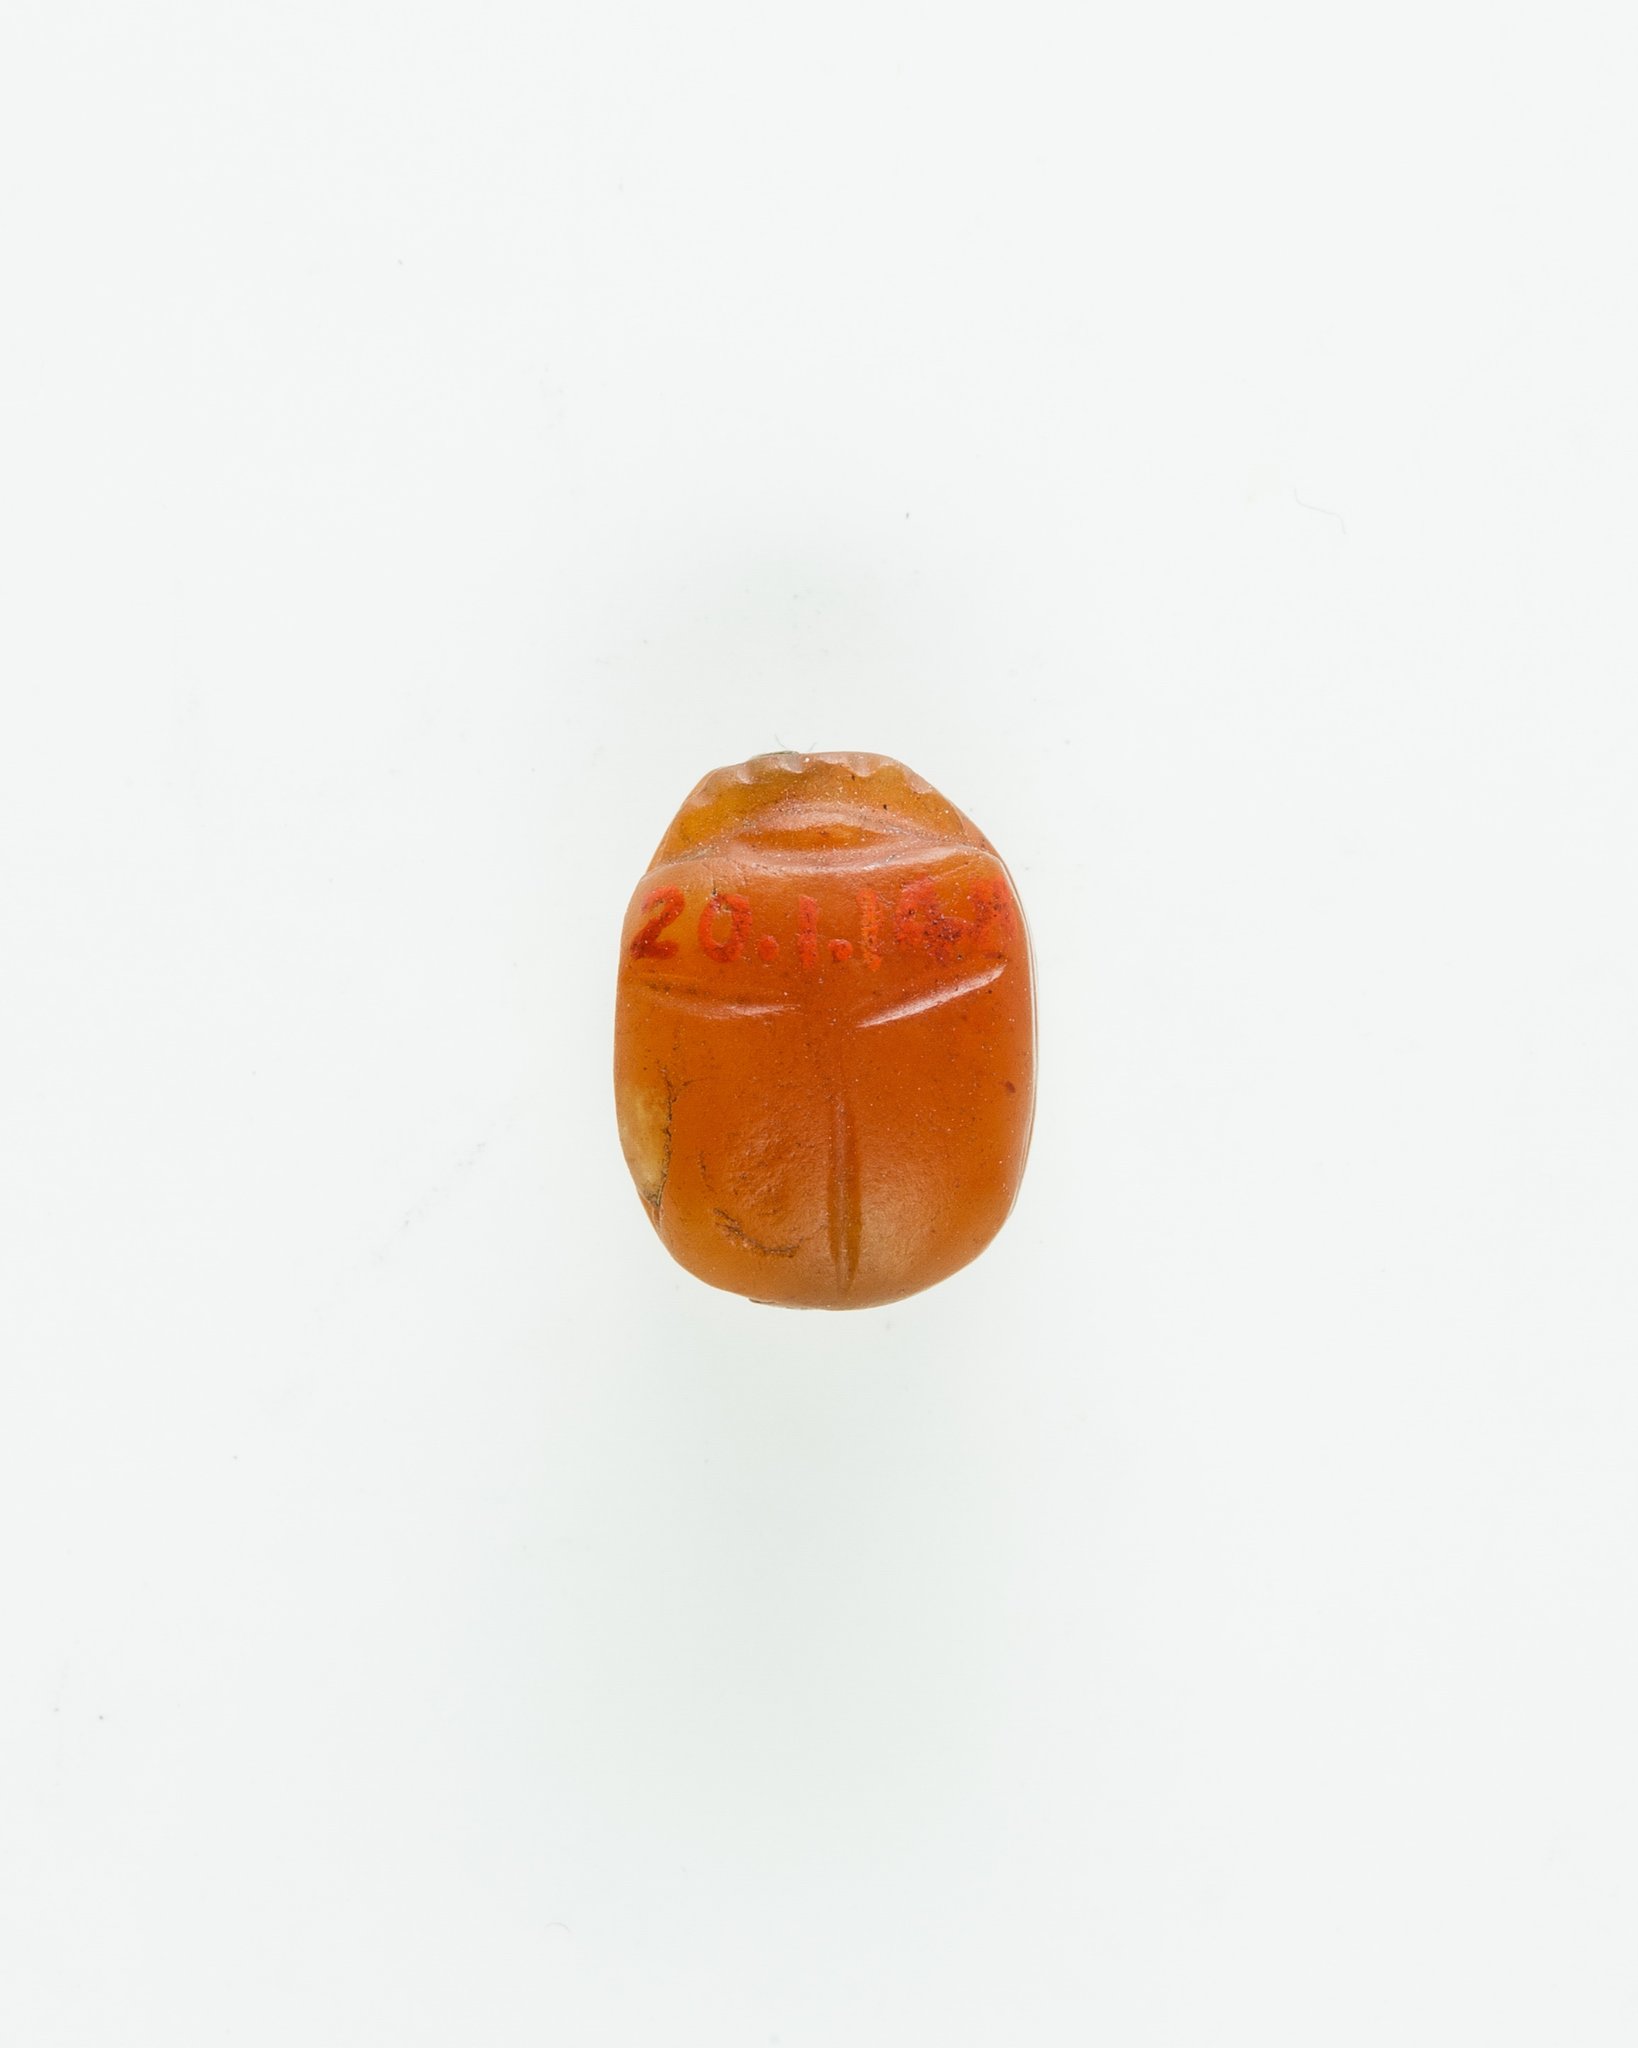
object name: scarab, geometric, cross, linear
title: Scarab Decorated with Crossing Lines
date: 1550-1295 BCE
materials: gemstone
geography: egypt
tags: scarabs